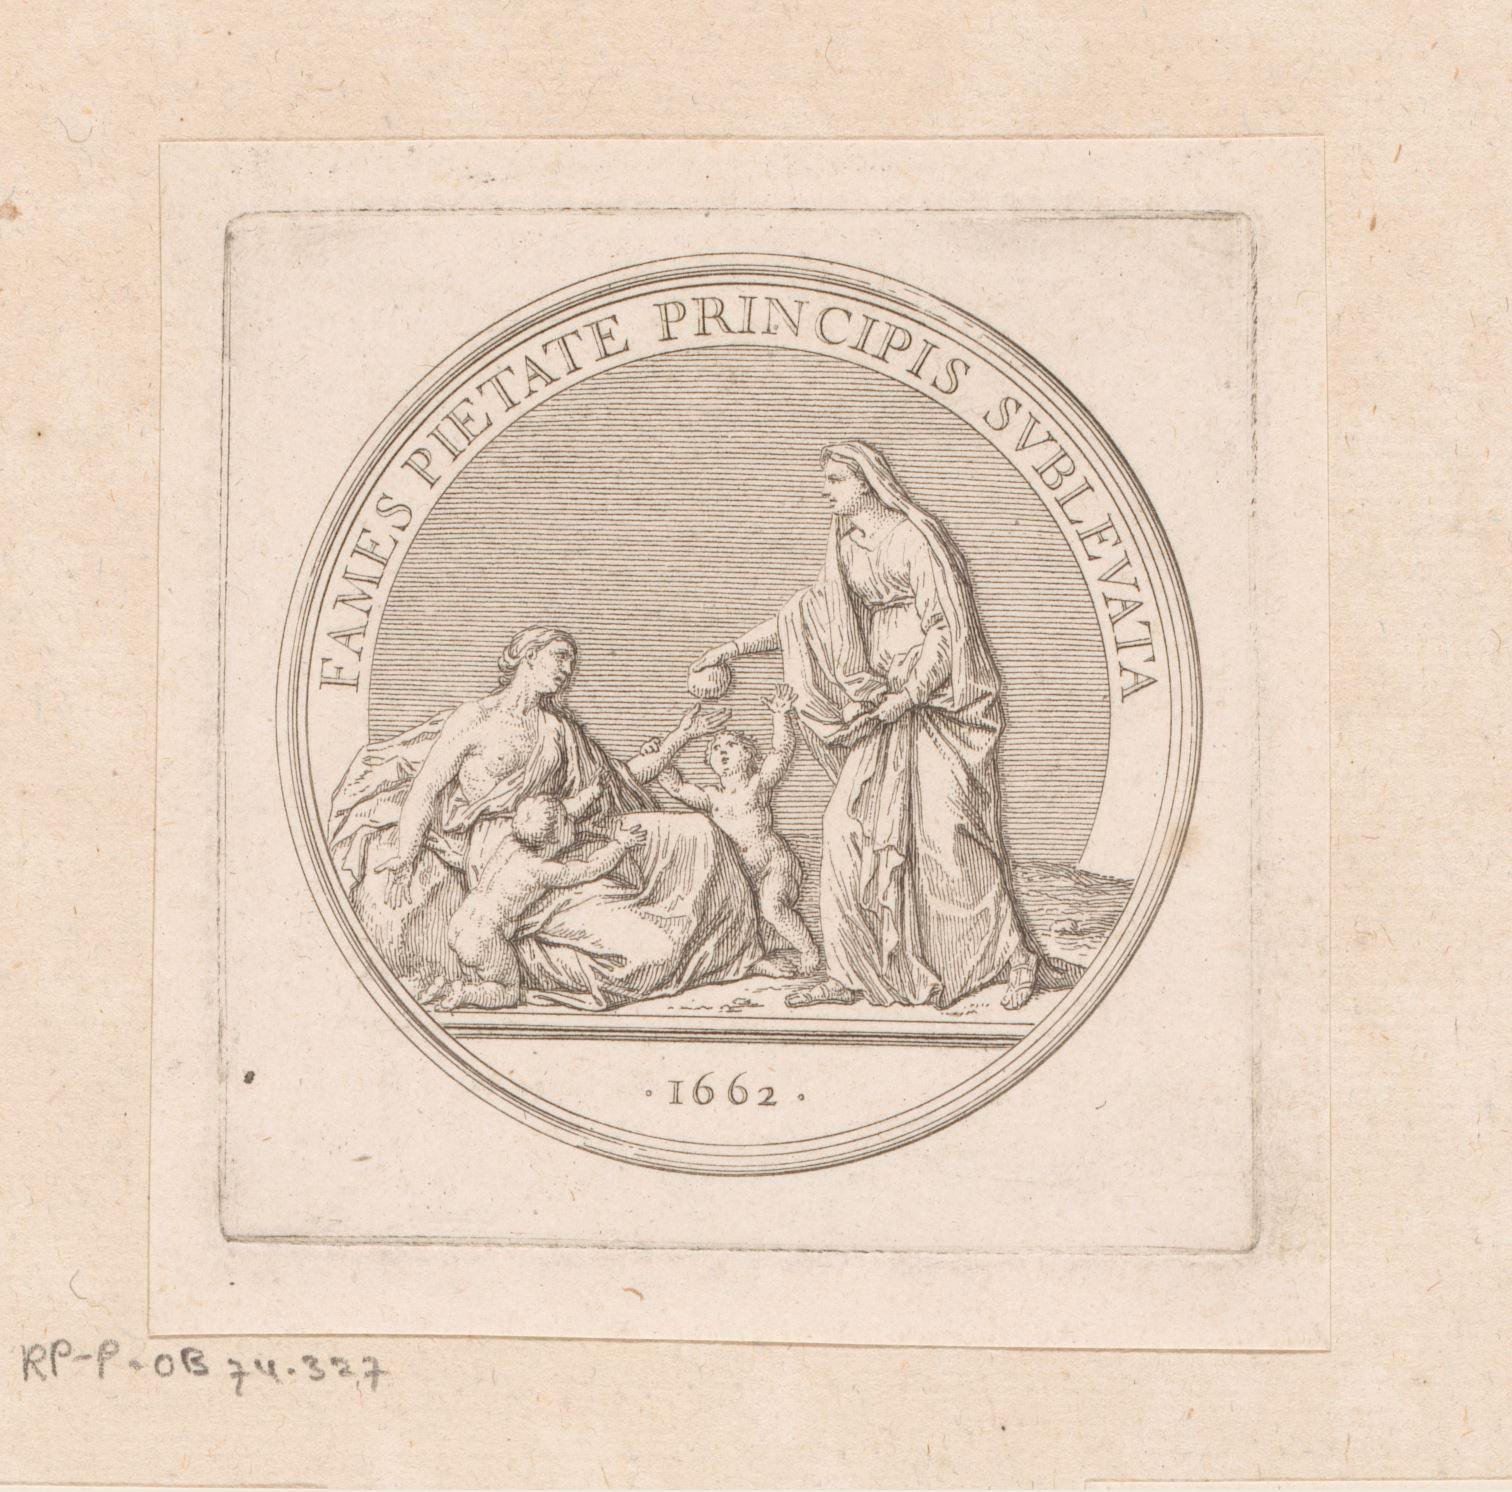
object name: book illustration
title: Vrouw reikt voedsel uit aan vrouw met twee kinderen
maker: charles louis simonneau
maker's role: print maker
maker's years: 1645-1728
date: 1723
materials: paper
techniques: engraving, etching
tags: lodewijk xiv (koning van frankrijk), starvation, famine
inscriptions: collector's mark: Lugt 240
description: Prent uit: Académie des inscriptions et belles-lettres. Medailles sur les principaux evenements du regne entier de Louis de Grand, avec des explications historiques. Parijs: Imprimerie Royale, 1723, p. 70.